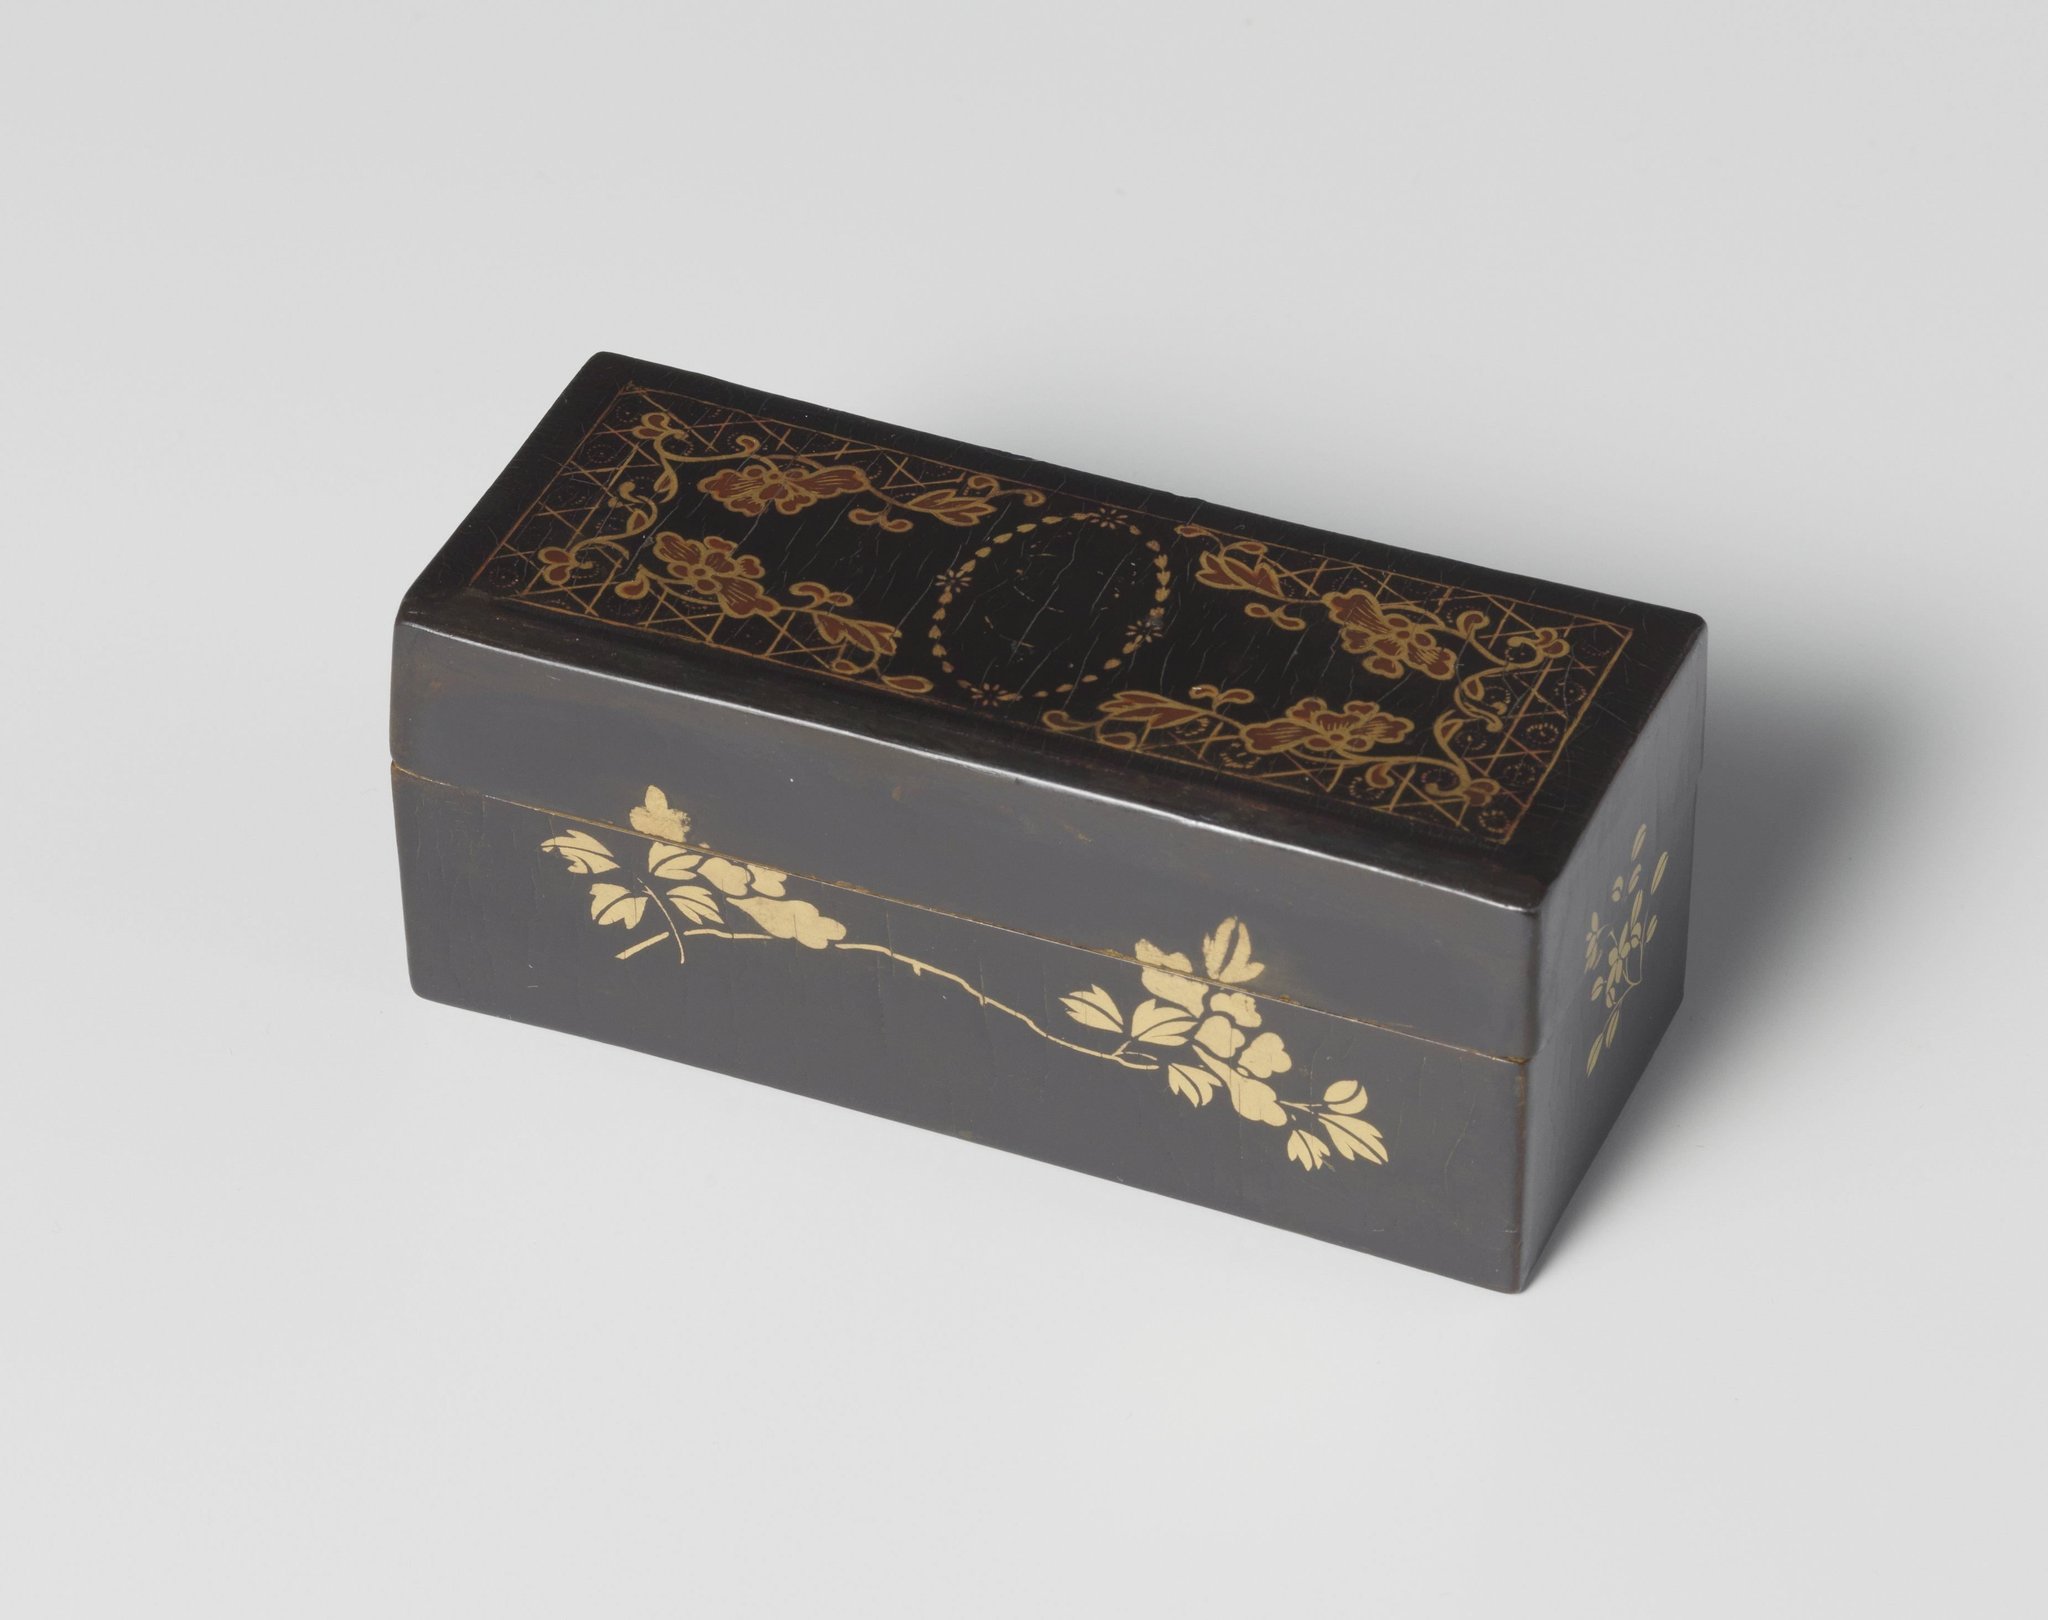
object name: dressing case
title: Box from Van Braam Houckgeest's toilet set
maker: Anonymous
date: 1795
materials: lacquer, glass, wood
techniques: lacquer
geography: guangdong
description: Rechthoekige doos behorend bij de spiegelstandaard AK-RAK-2003-8-1. Bedekt met zwarte lak met gouden decoraties. Op de deksel een monogram ECVB omgeven door een smalle b and met bladmotieven en vier kleine bloemen. Rond het centrale medaillon een bloemband en buiten deze band is het oppervlak gevuld met geometrische motieven. Op de zijkanten losse bloemtakken.